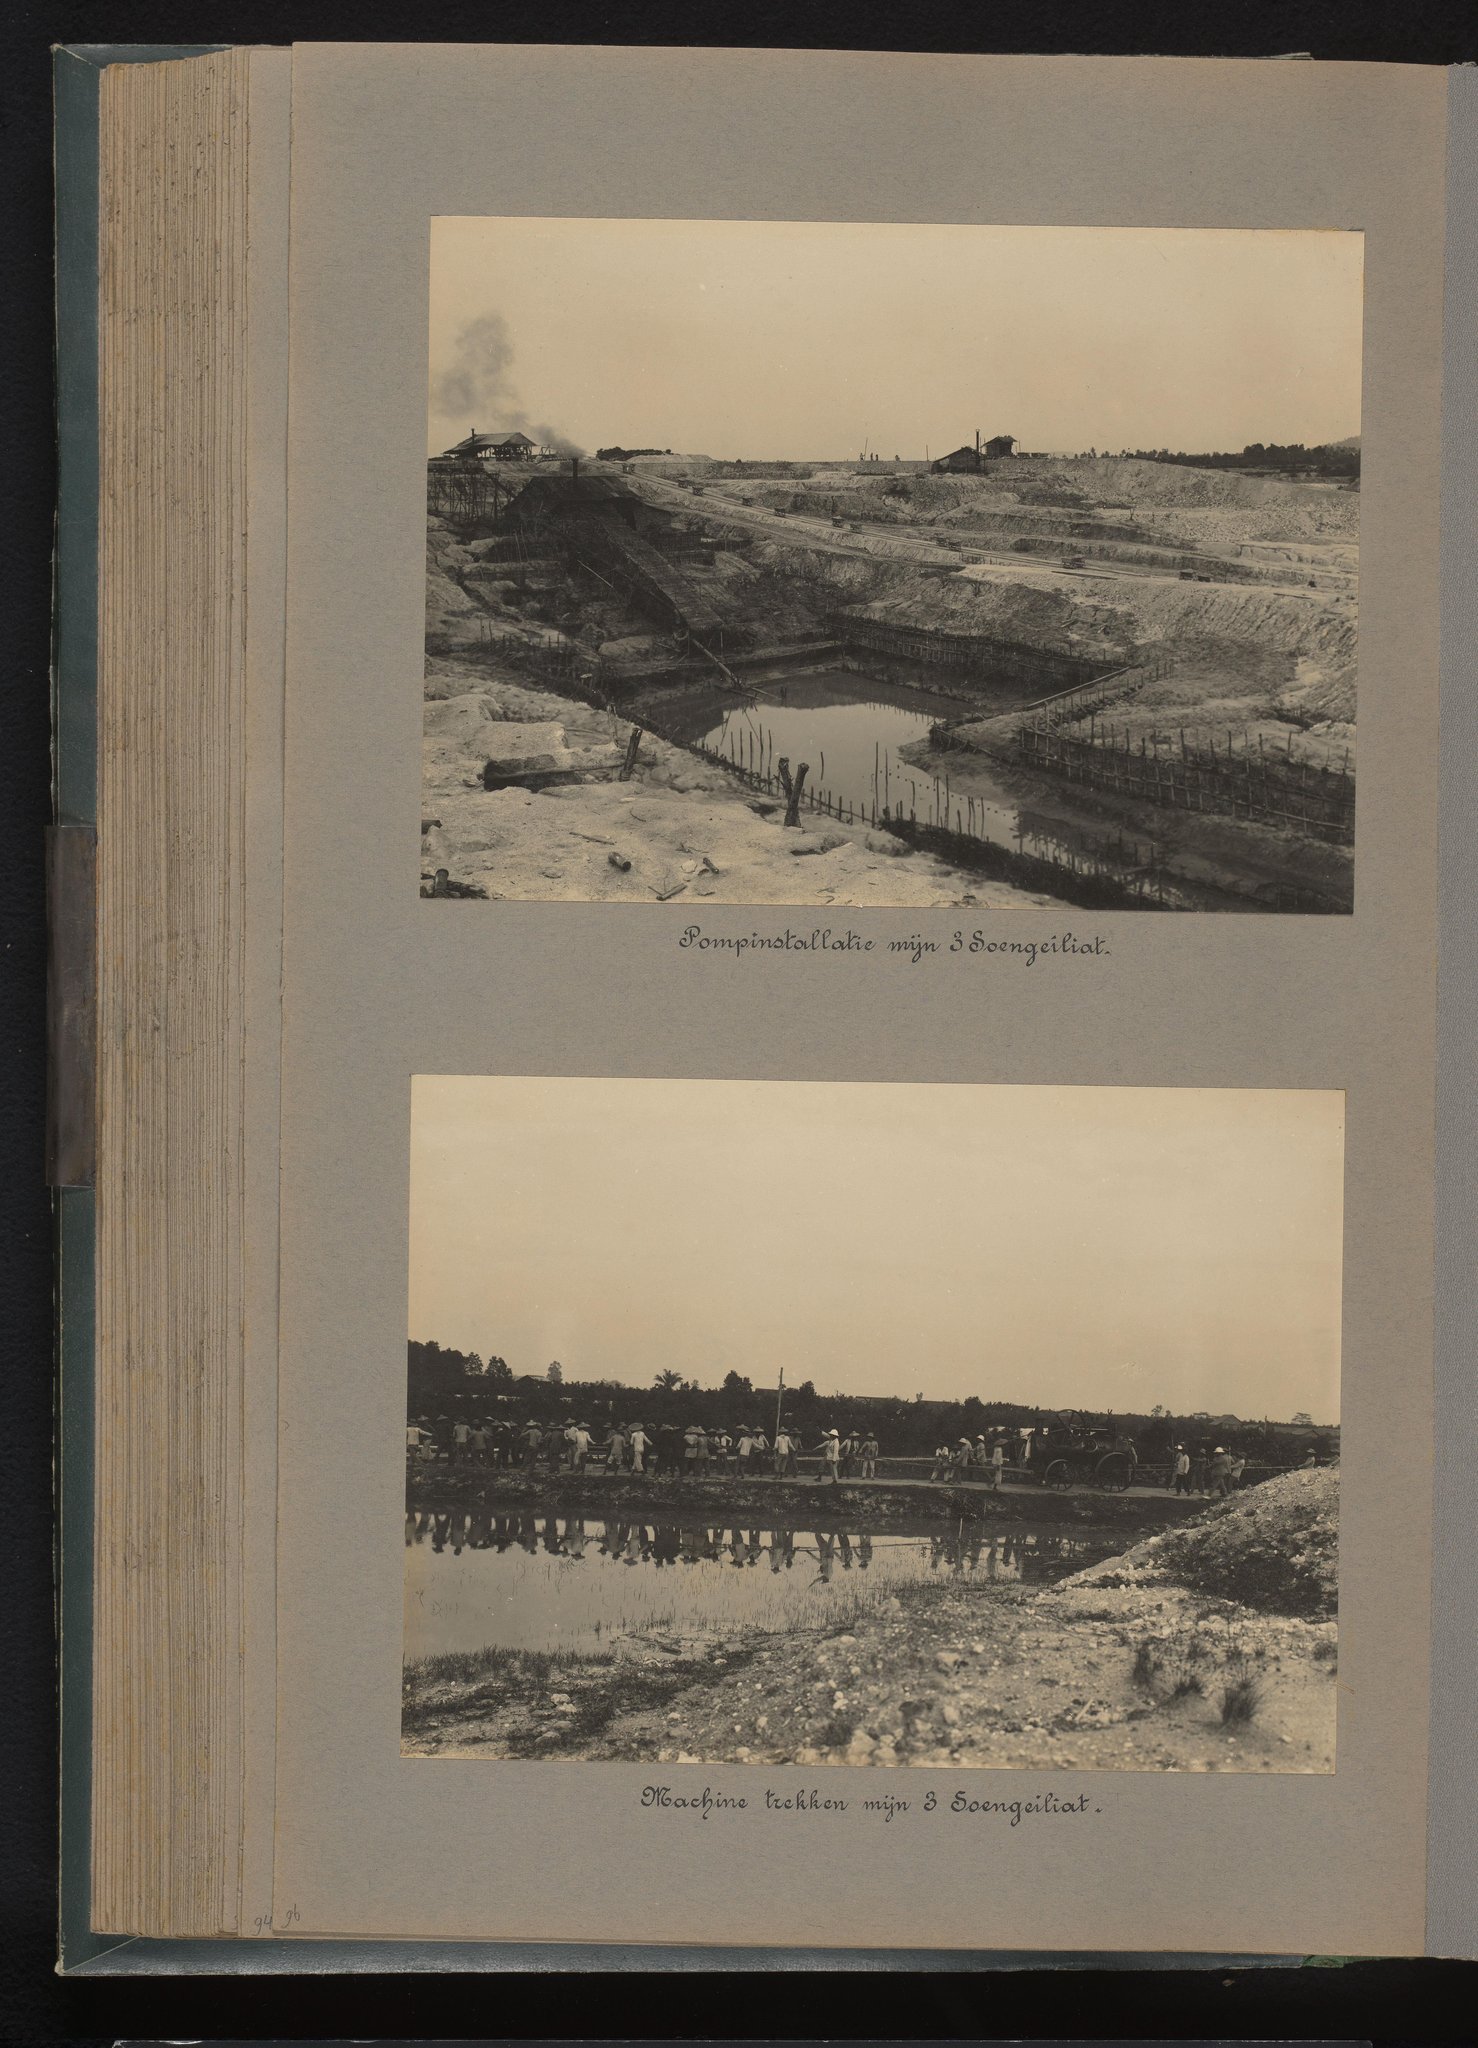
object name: album leaf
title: Werkzaamheden in een mijn van de Banka-tinwinning te Soengeiliat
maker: Anonymous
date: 1914-1919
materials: cardboard, photographic support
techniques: gelatin silver print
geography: bangka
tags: robert julius boers, colonial system, opencast mine; strip mining, working class, labourers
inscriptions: inscription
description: Albumblad met 2 foto's van een pompinstallatie en van arbeiders aan het werk in mijn 3 van de Banka-tinwinning te Soengeiliat. Onderdeel van het fotoalbum aangeboden aan Robert Julius Boers bij zijn vertrek naar Nederland in 1919 door het personeel van de Banka-tinwinning.